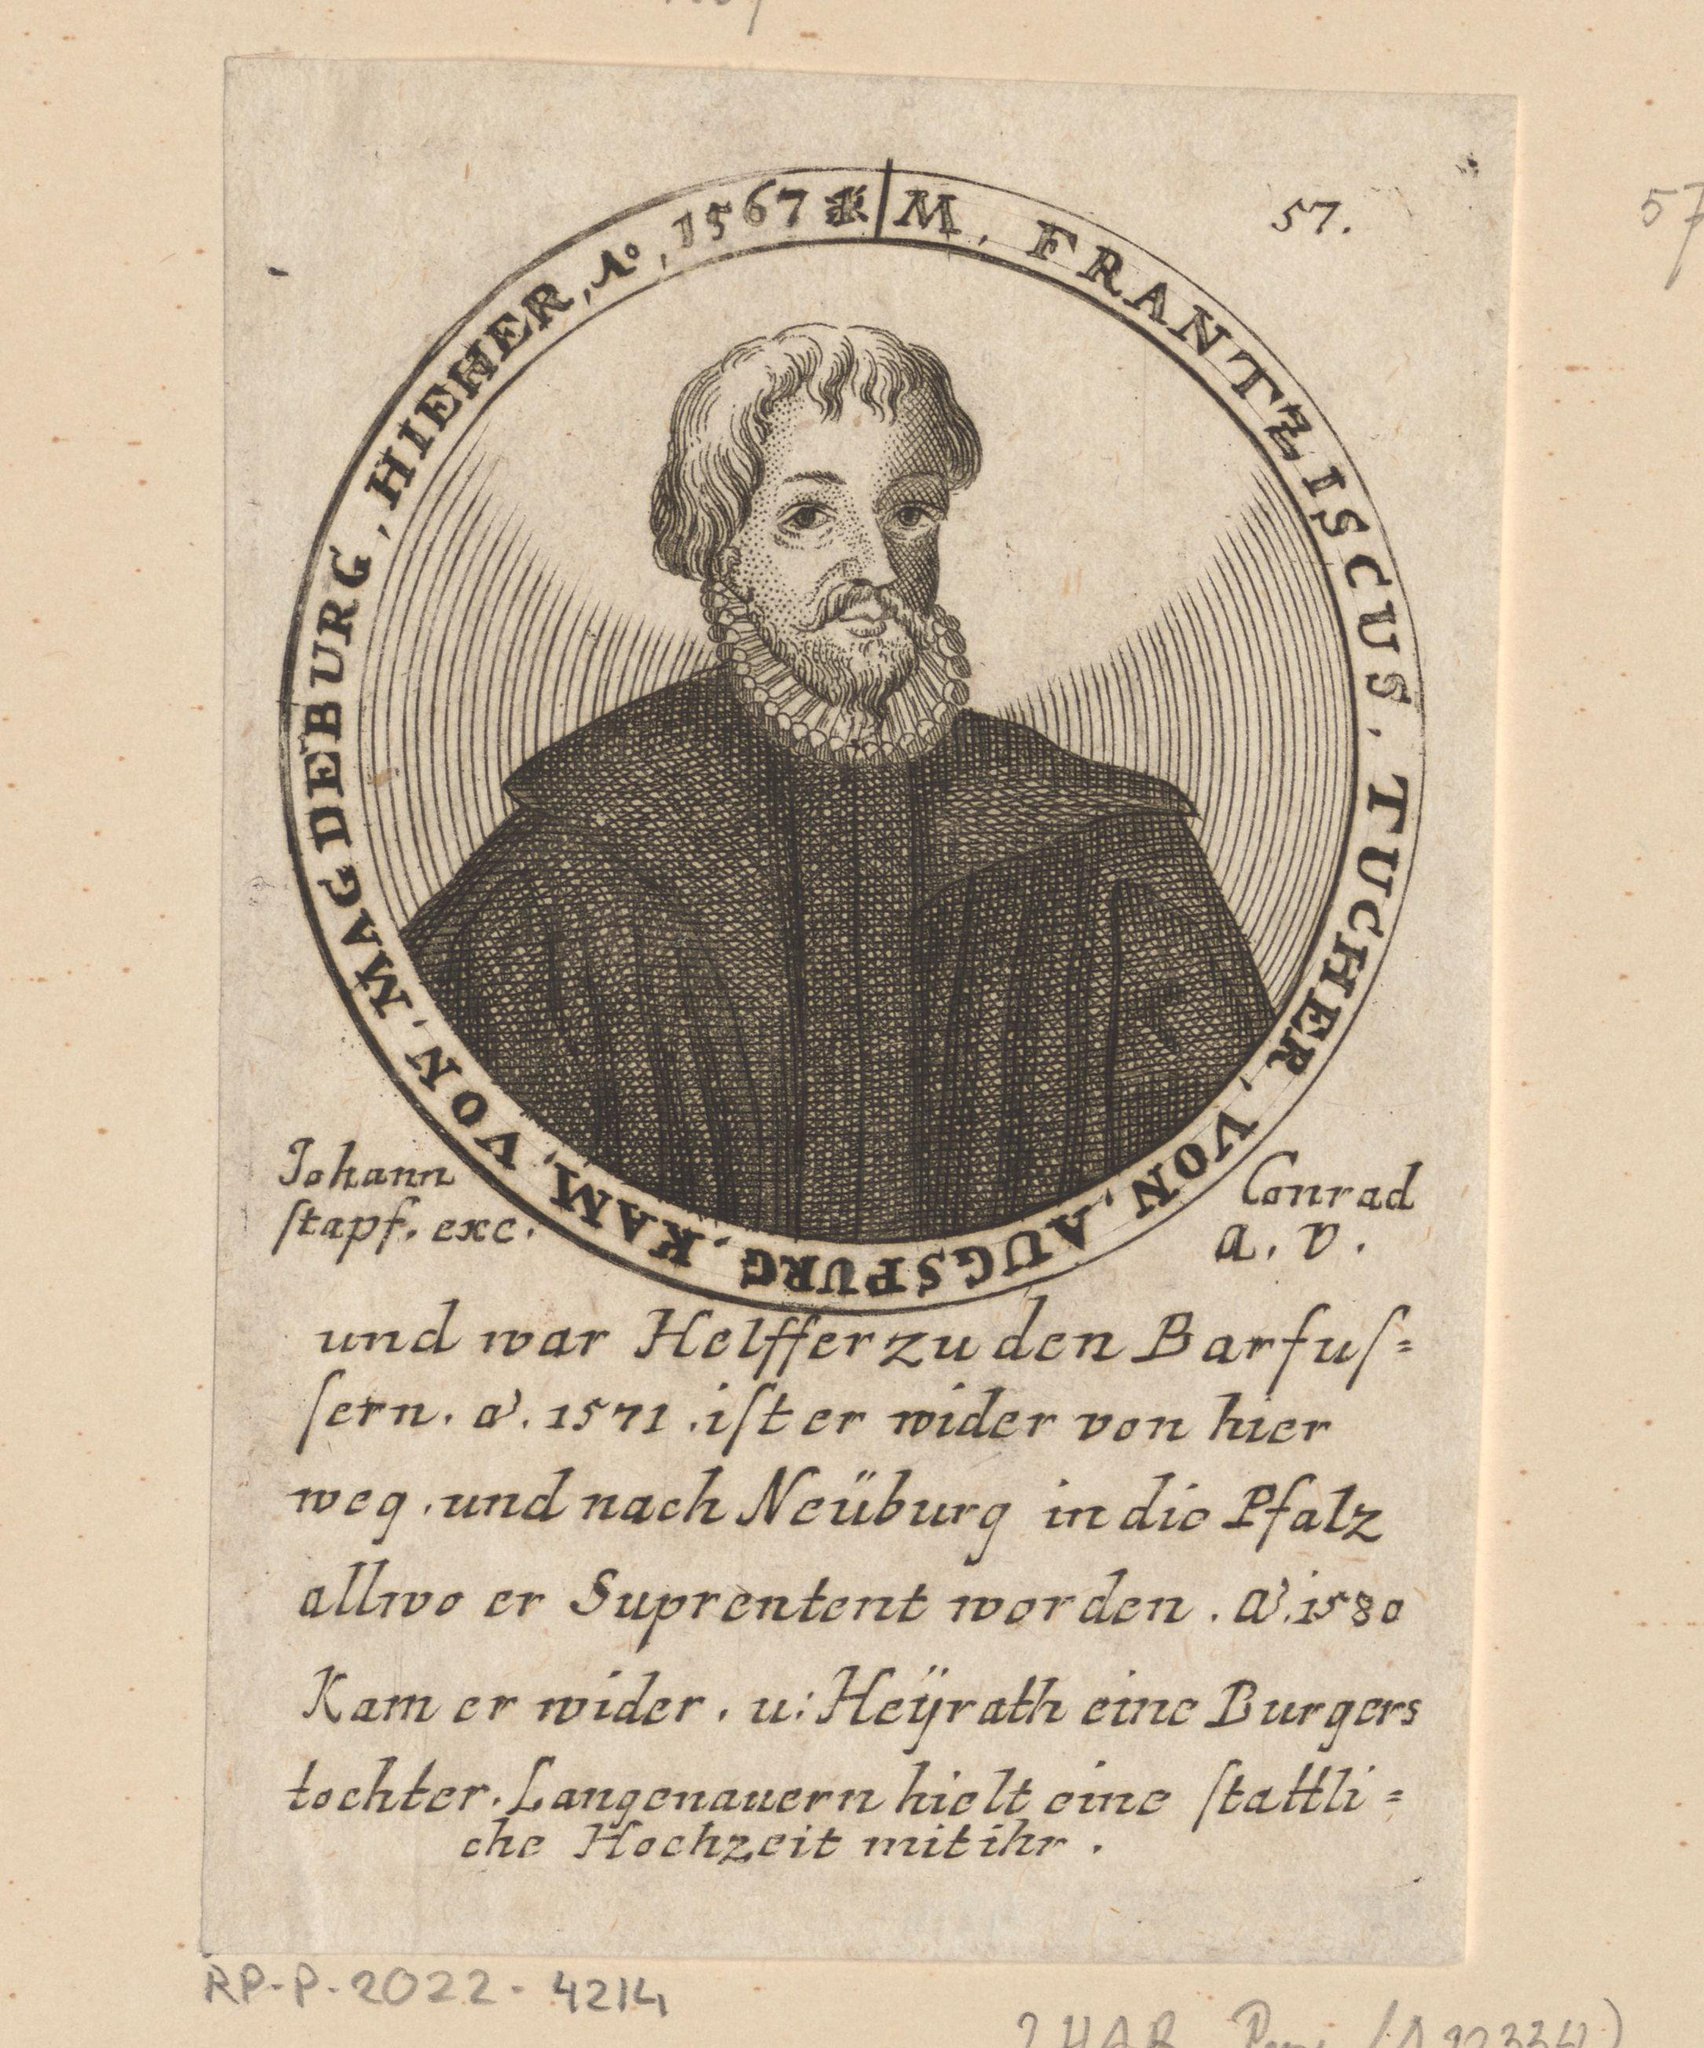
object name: print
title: Portret van Franz Tucher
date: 1567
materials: paper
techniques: engraving, etching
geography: germany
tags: theologian, historical persons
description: Met zevenregelig onderschrift in het Duits. Rechtsboven genummerd: 57.